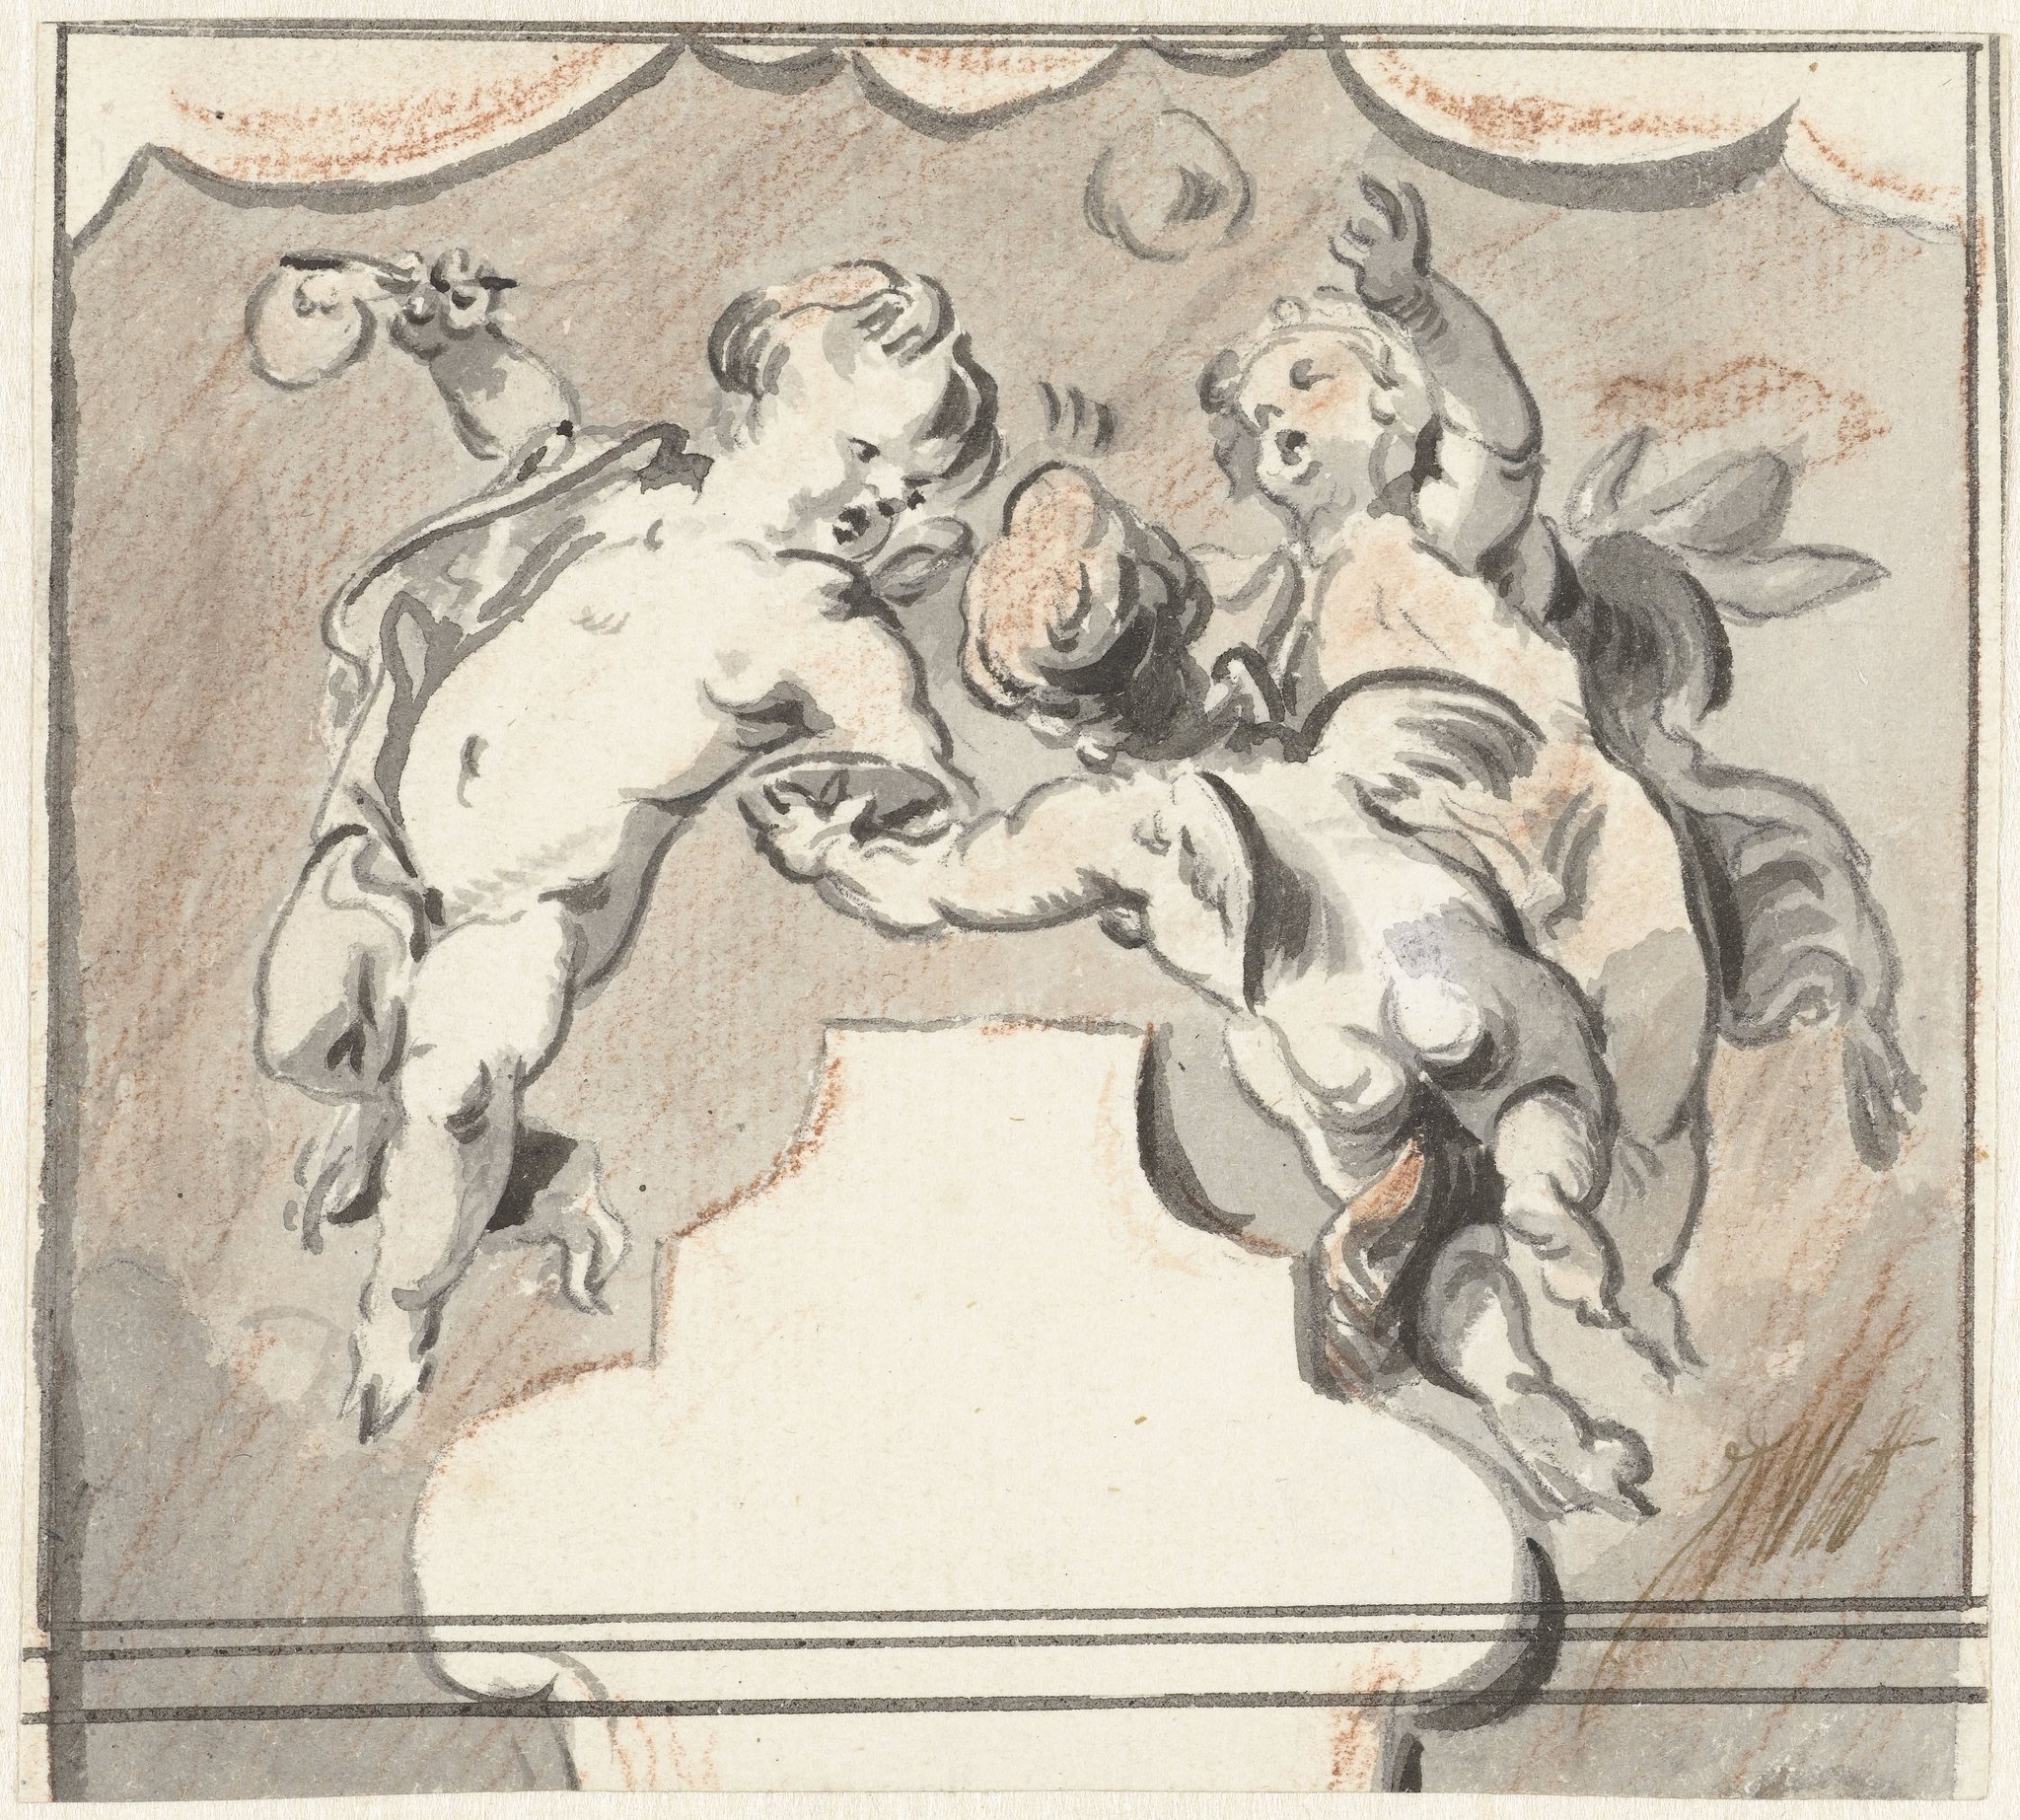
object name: drawing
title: Drie zwevende putti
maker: jacob de wit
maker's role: draughtsman, painter, print maker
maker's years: 1695-1754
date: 1705-1754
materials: chalk, ink, paper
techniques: brush, pen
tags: movement in the air, cupids: 'amores', 'amoretti', 'putti', (children or putti) blowing bubbles, 'homo bulla' ~ scene symbolizing 'vanitas'